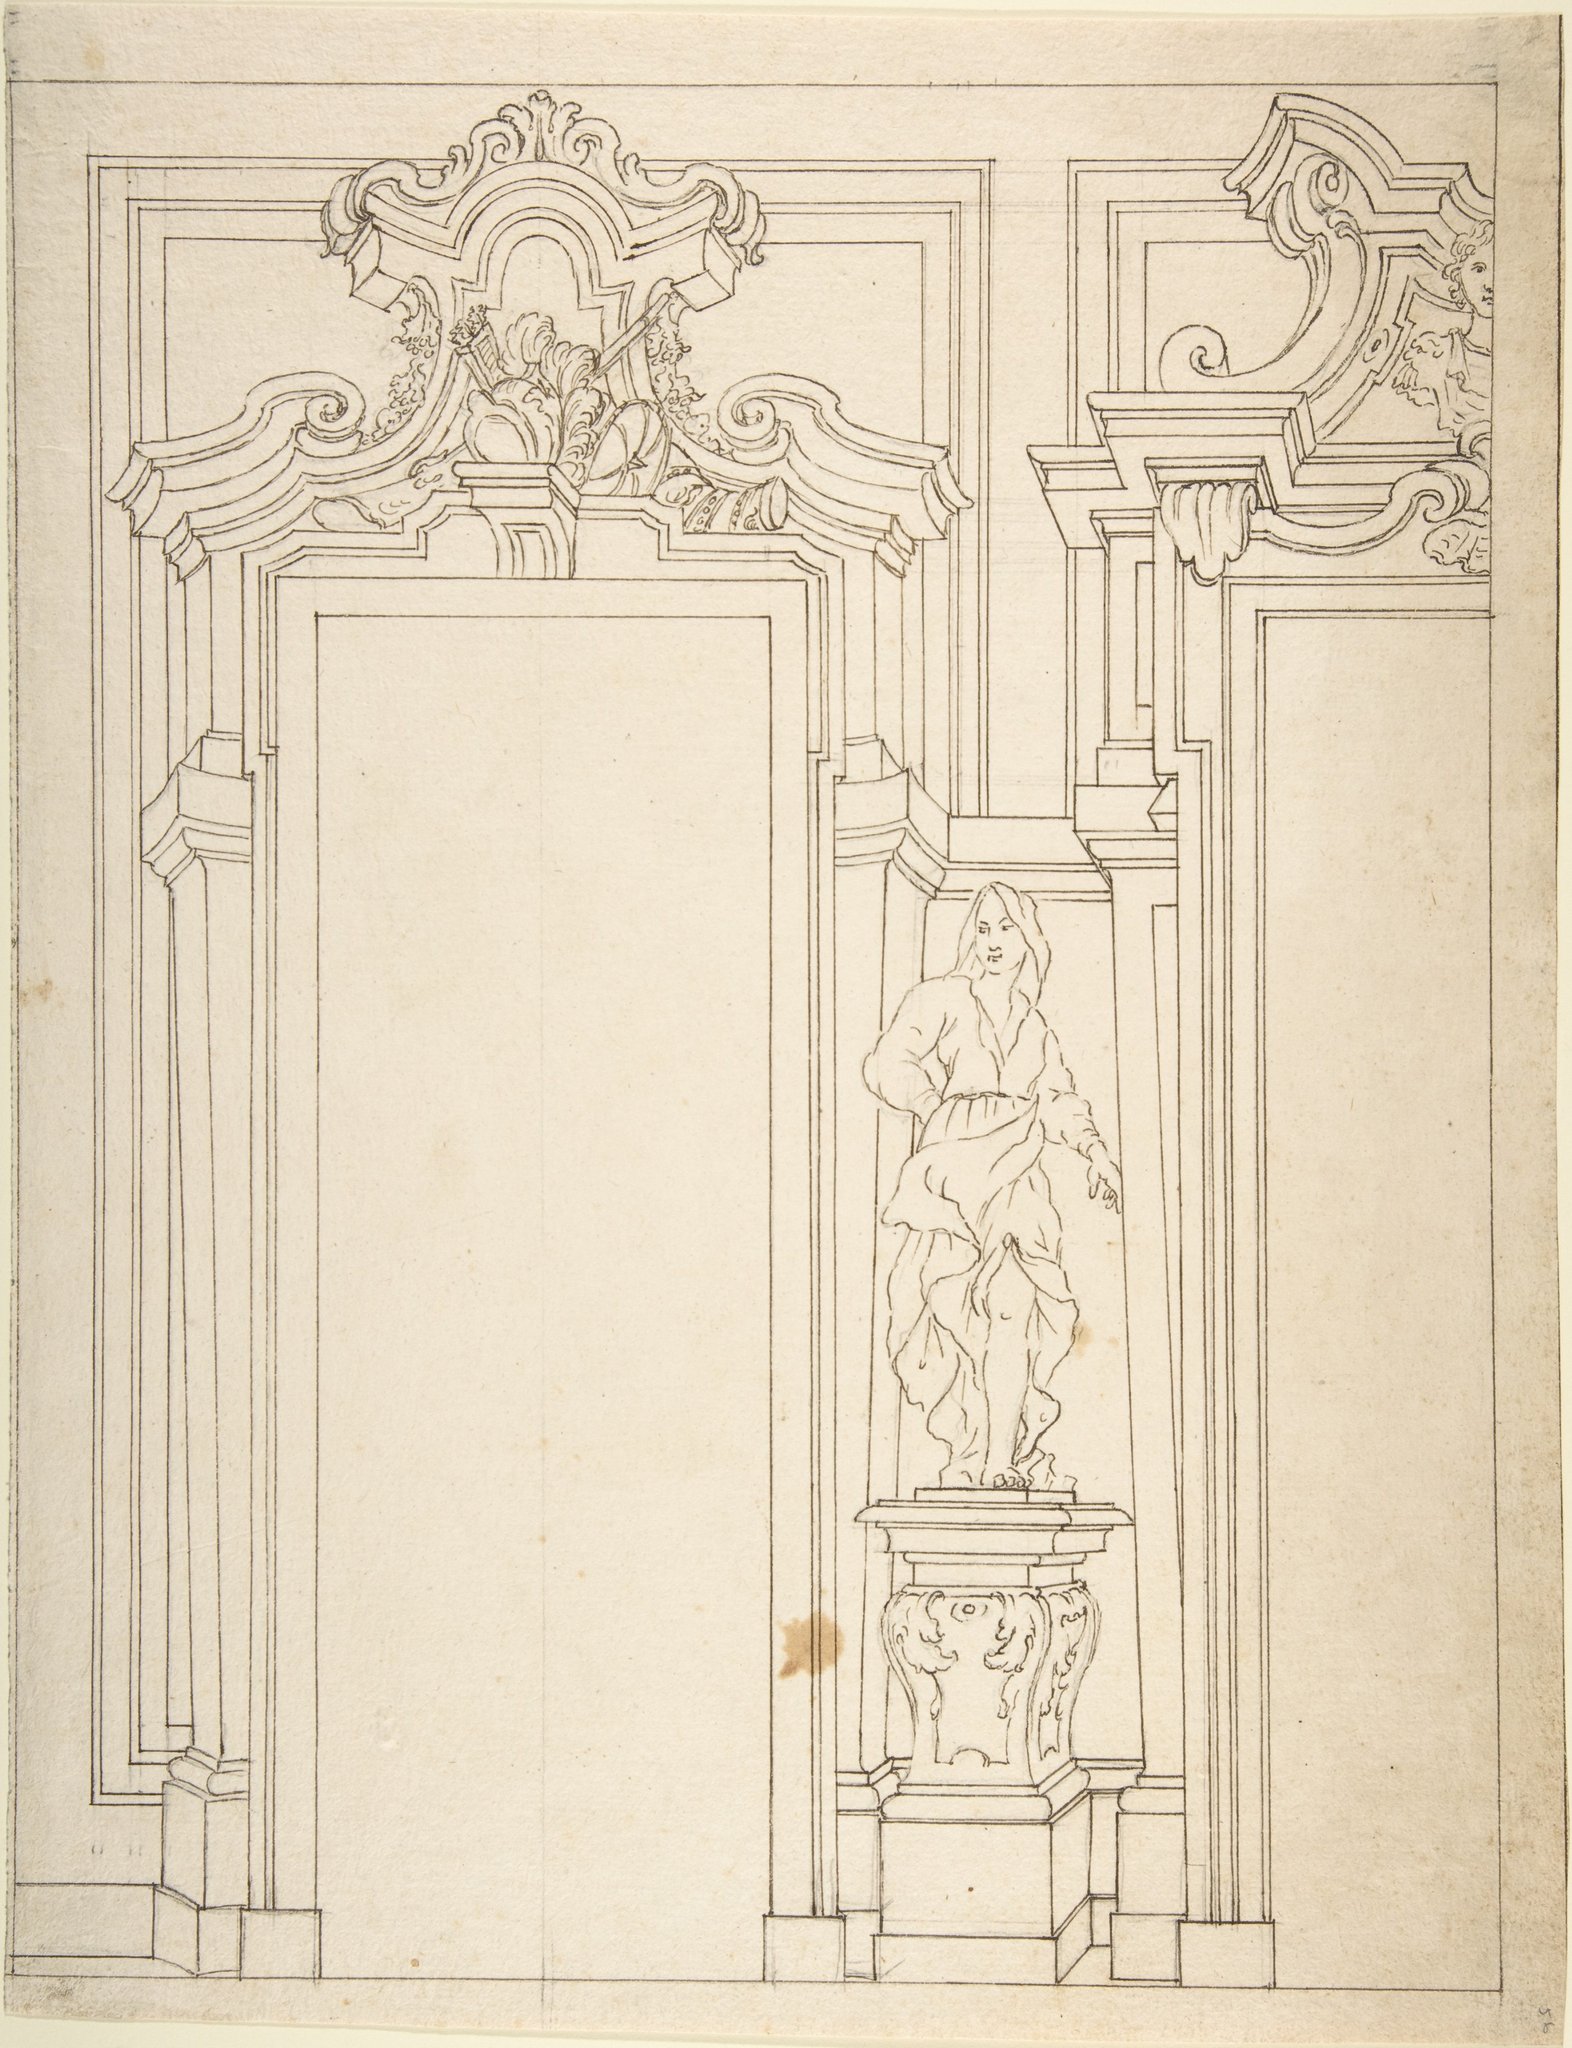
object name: drawing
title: Design for the Elevation of a Wall Interior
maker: anonymous, italian, piedmontese, 18th century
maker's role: artist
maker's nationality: italian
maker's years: 1700-1800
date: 1700-1780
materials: ink, drawing material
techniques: pen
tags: human figures